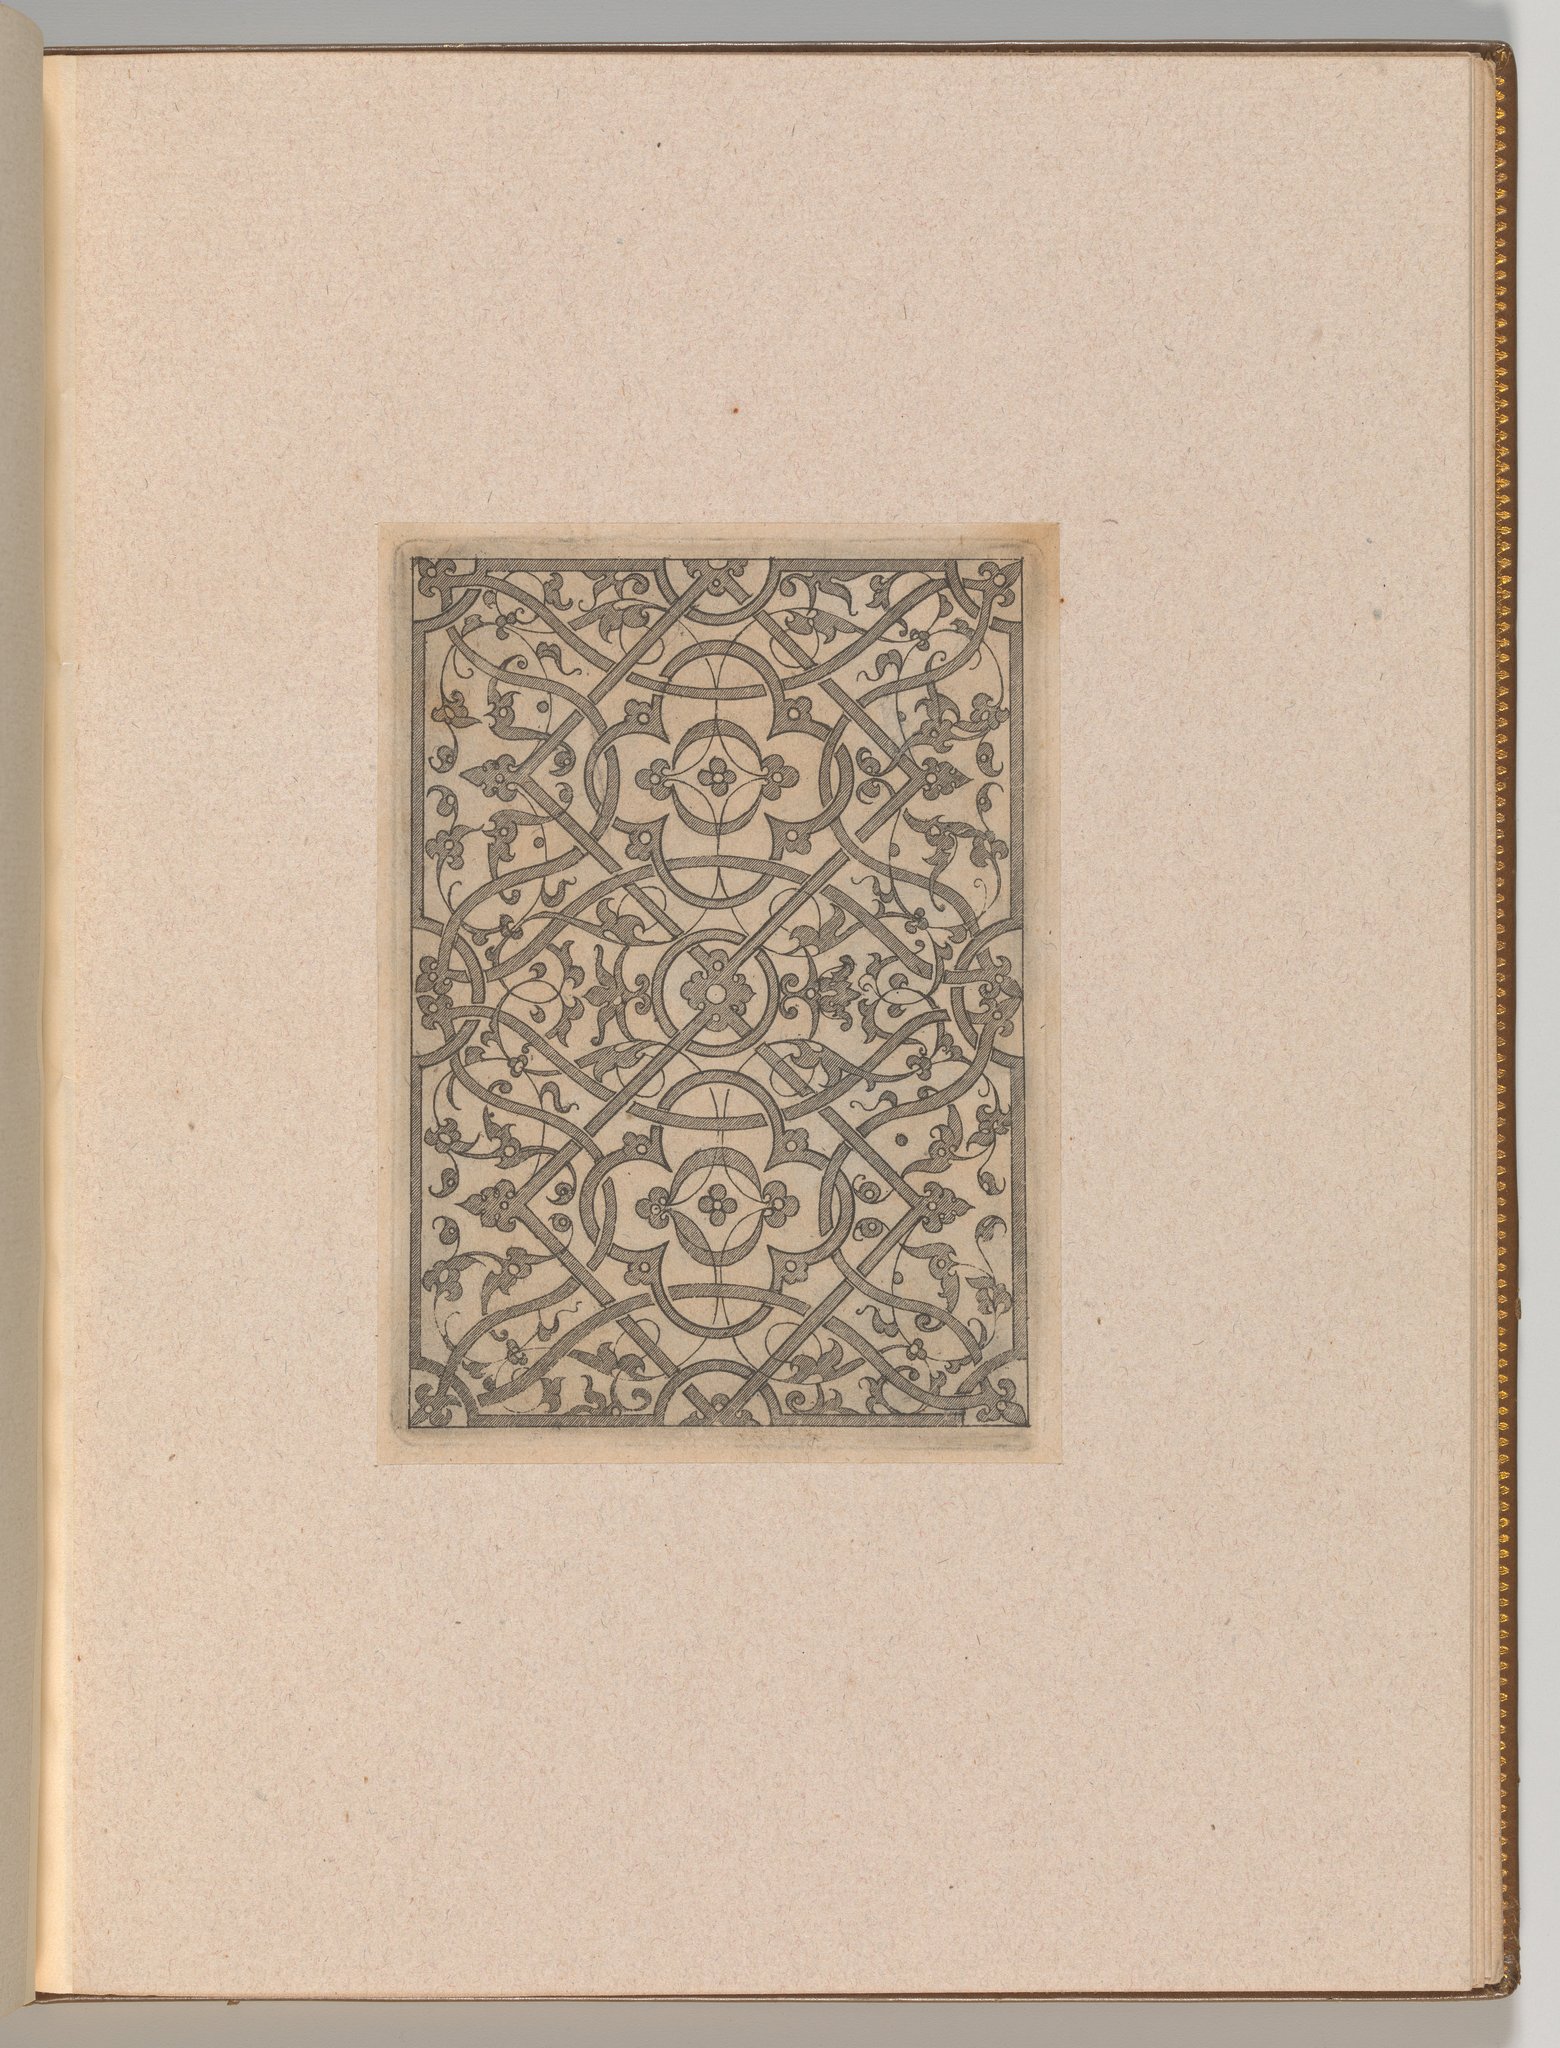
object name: album print ornament architecture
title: Copies after the 'Livre contenant passement de moresques' (plate 3)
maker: jacques androuet du cerceau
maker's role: artist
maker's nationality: french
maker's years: 1510-1585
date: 1801-1900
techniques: etching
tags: ornament